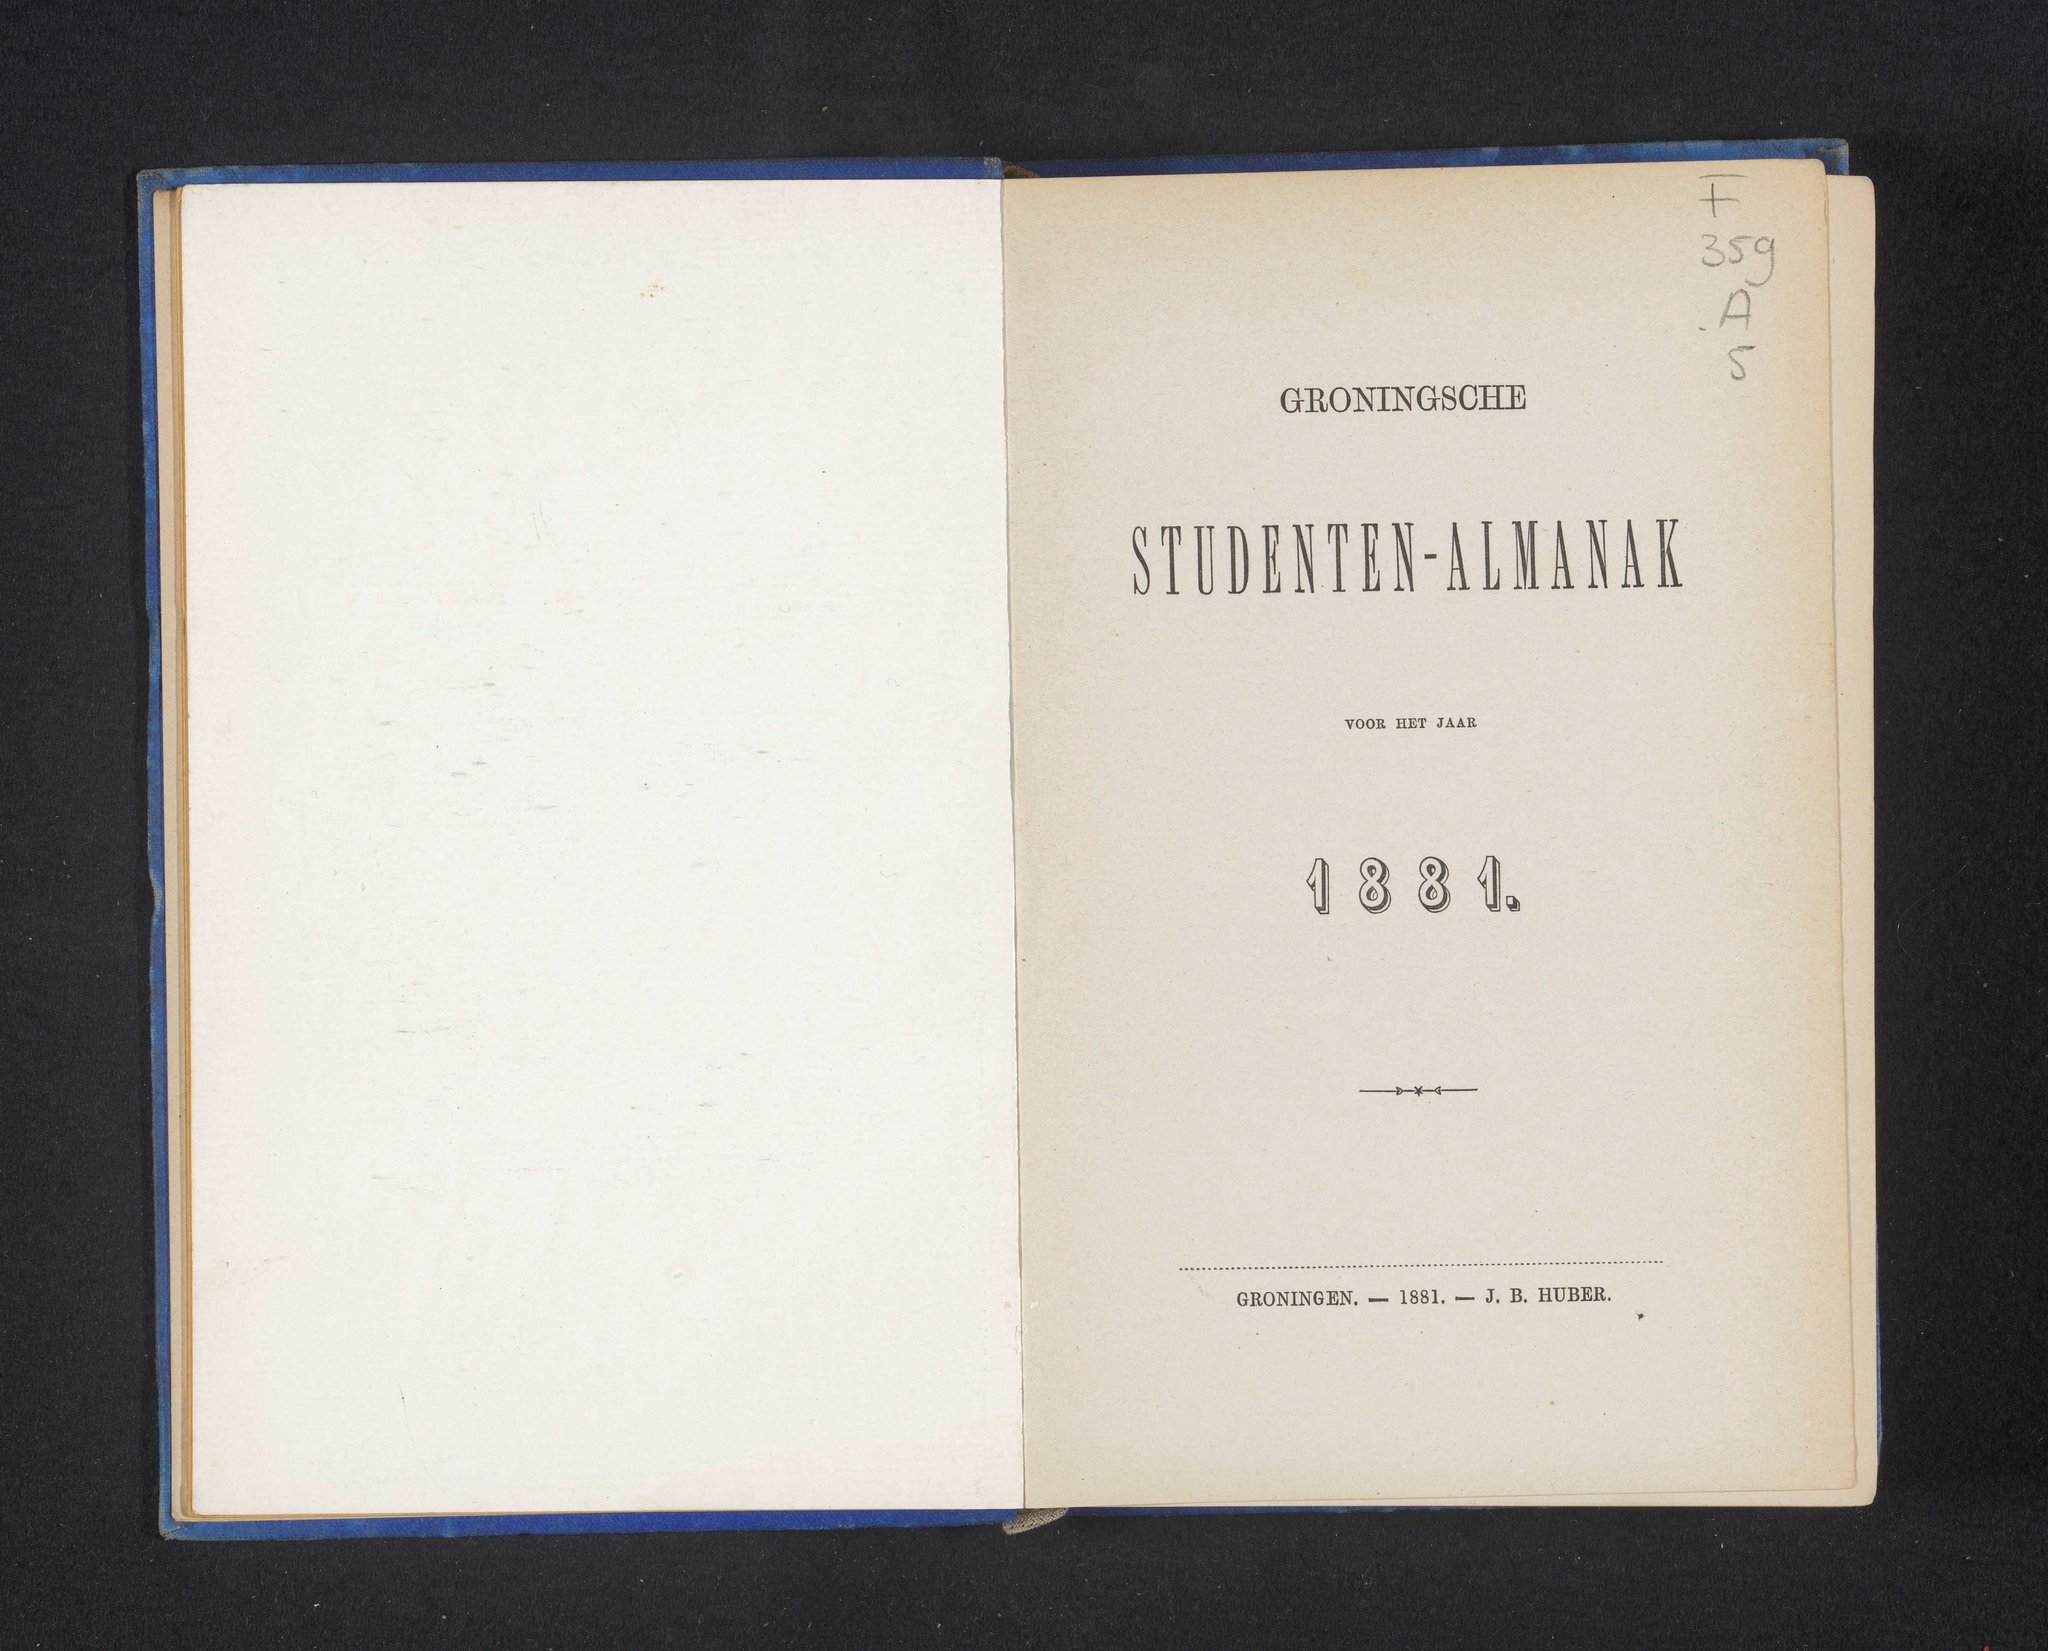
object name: book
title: Groninger studenten almanak voor het jaar 1881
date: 1881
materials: cardboard, linen, paper, photographic support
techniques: albumen print, lithograph, printing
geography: groningen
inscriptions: annotation: ‘Den Hooggeleerden Heer/ Dr. F.J.P. van Calker./ Namens de Almanak-Redactie:/ [..]Bun[...] Boek[...]/ praeses.’, annotation: ‘Bouma's Boekhuis/ 11.10.40 f 0.75’